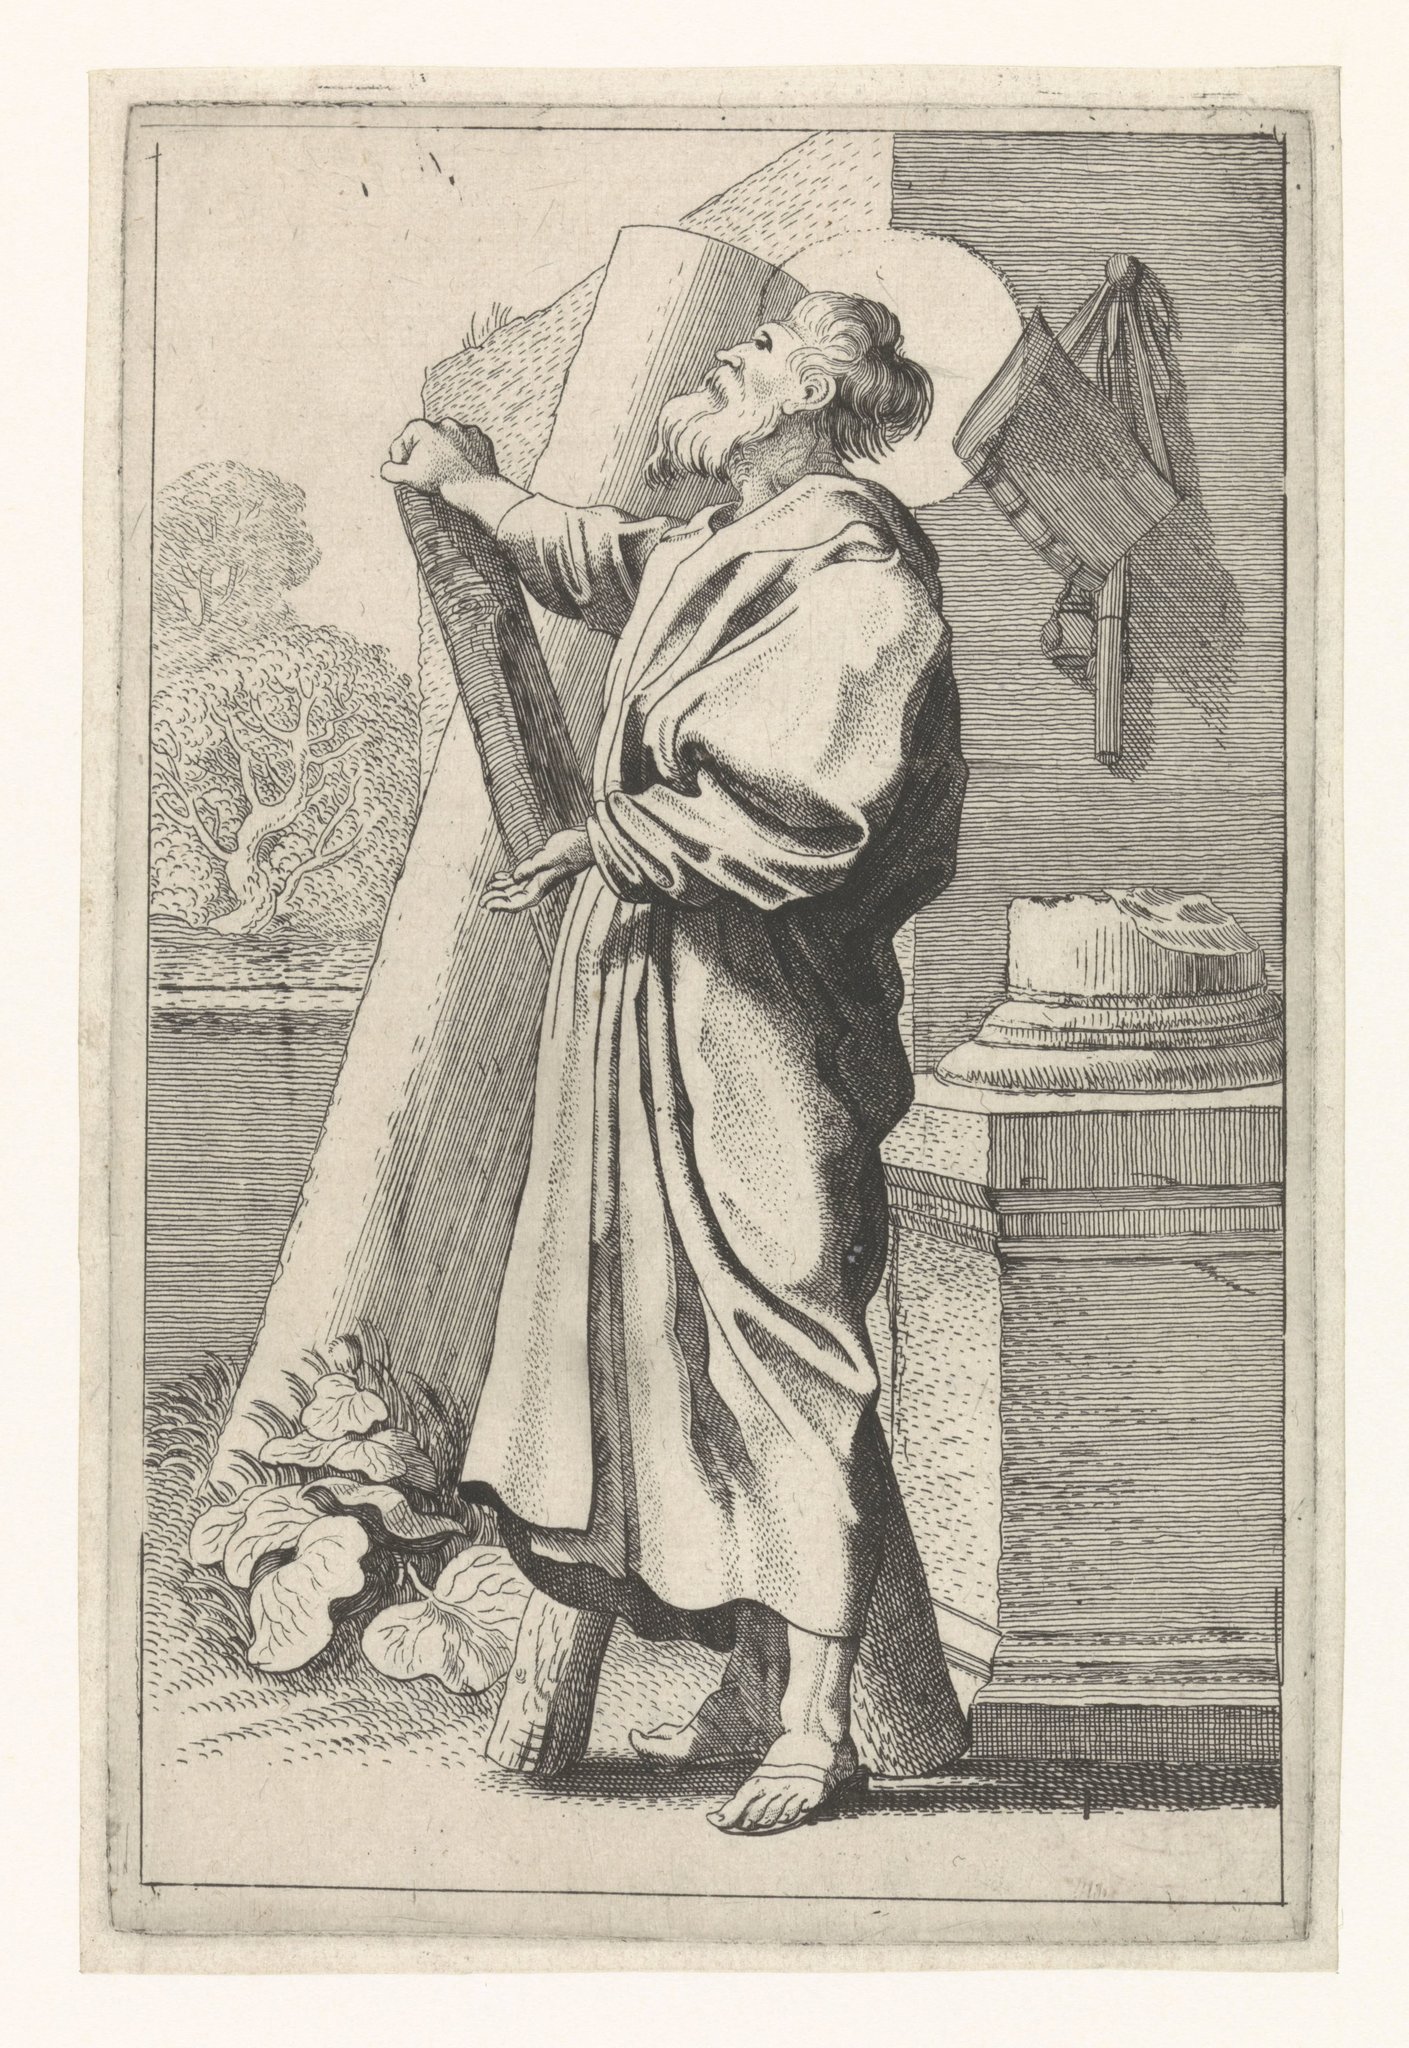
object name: print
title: H. Andreas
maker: jan van de velde (ii)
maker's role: draughtsman, painter, print maker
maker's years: 1593-1641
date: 1603-1641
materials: paper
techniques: engraving, etching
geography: northern netherlands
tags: the apostle andrew; possible attributes: book, x-shaped cross, fish, fishing-net, rope, scroll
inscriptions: collector's mark: Lugt 240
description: De heilige Adreas, met achter hem zijn kruis, staand voor een gebroken zuil, opkijkend naar de hemel.